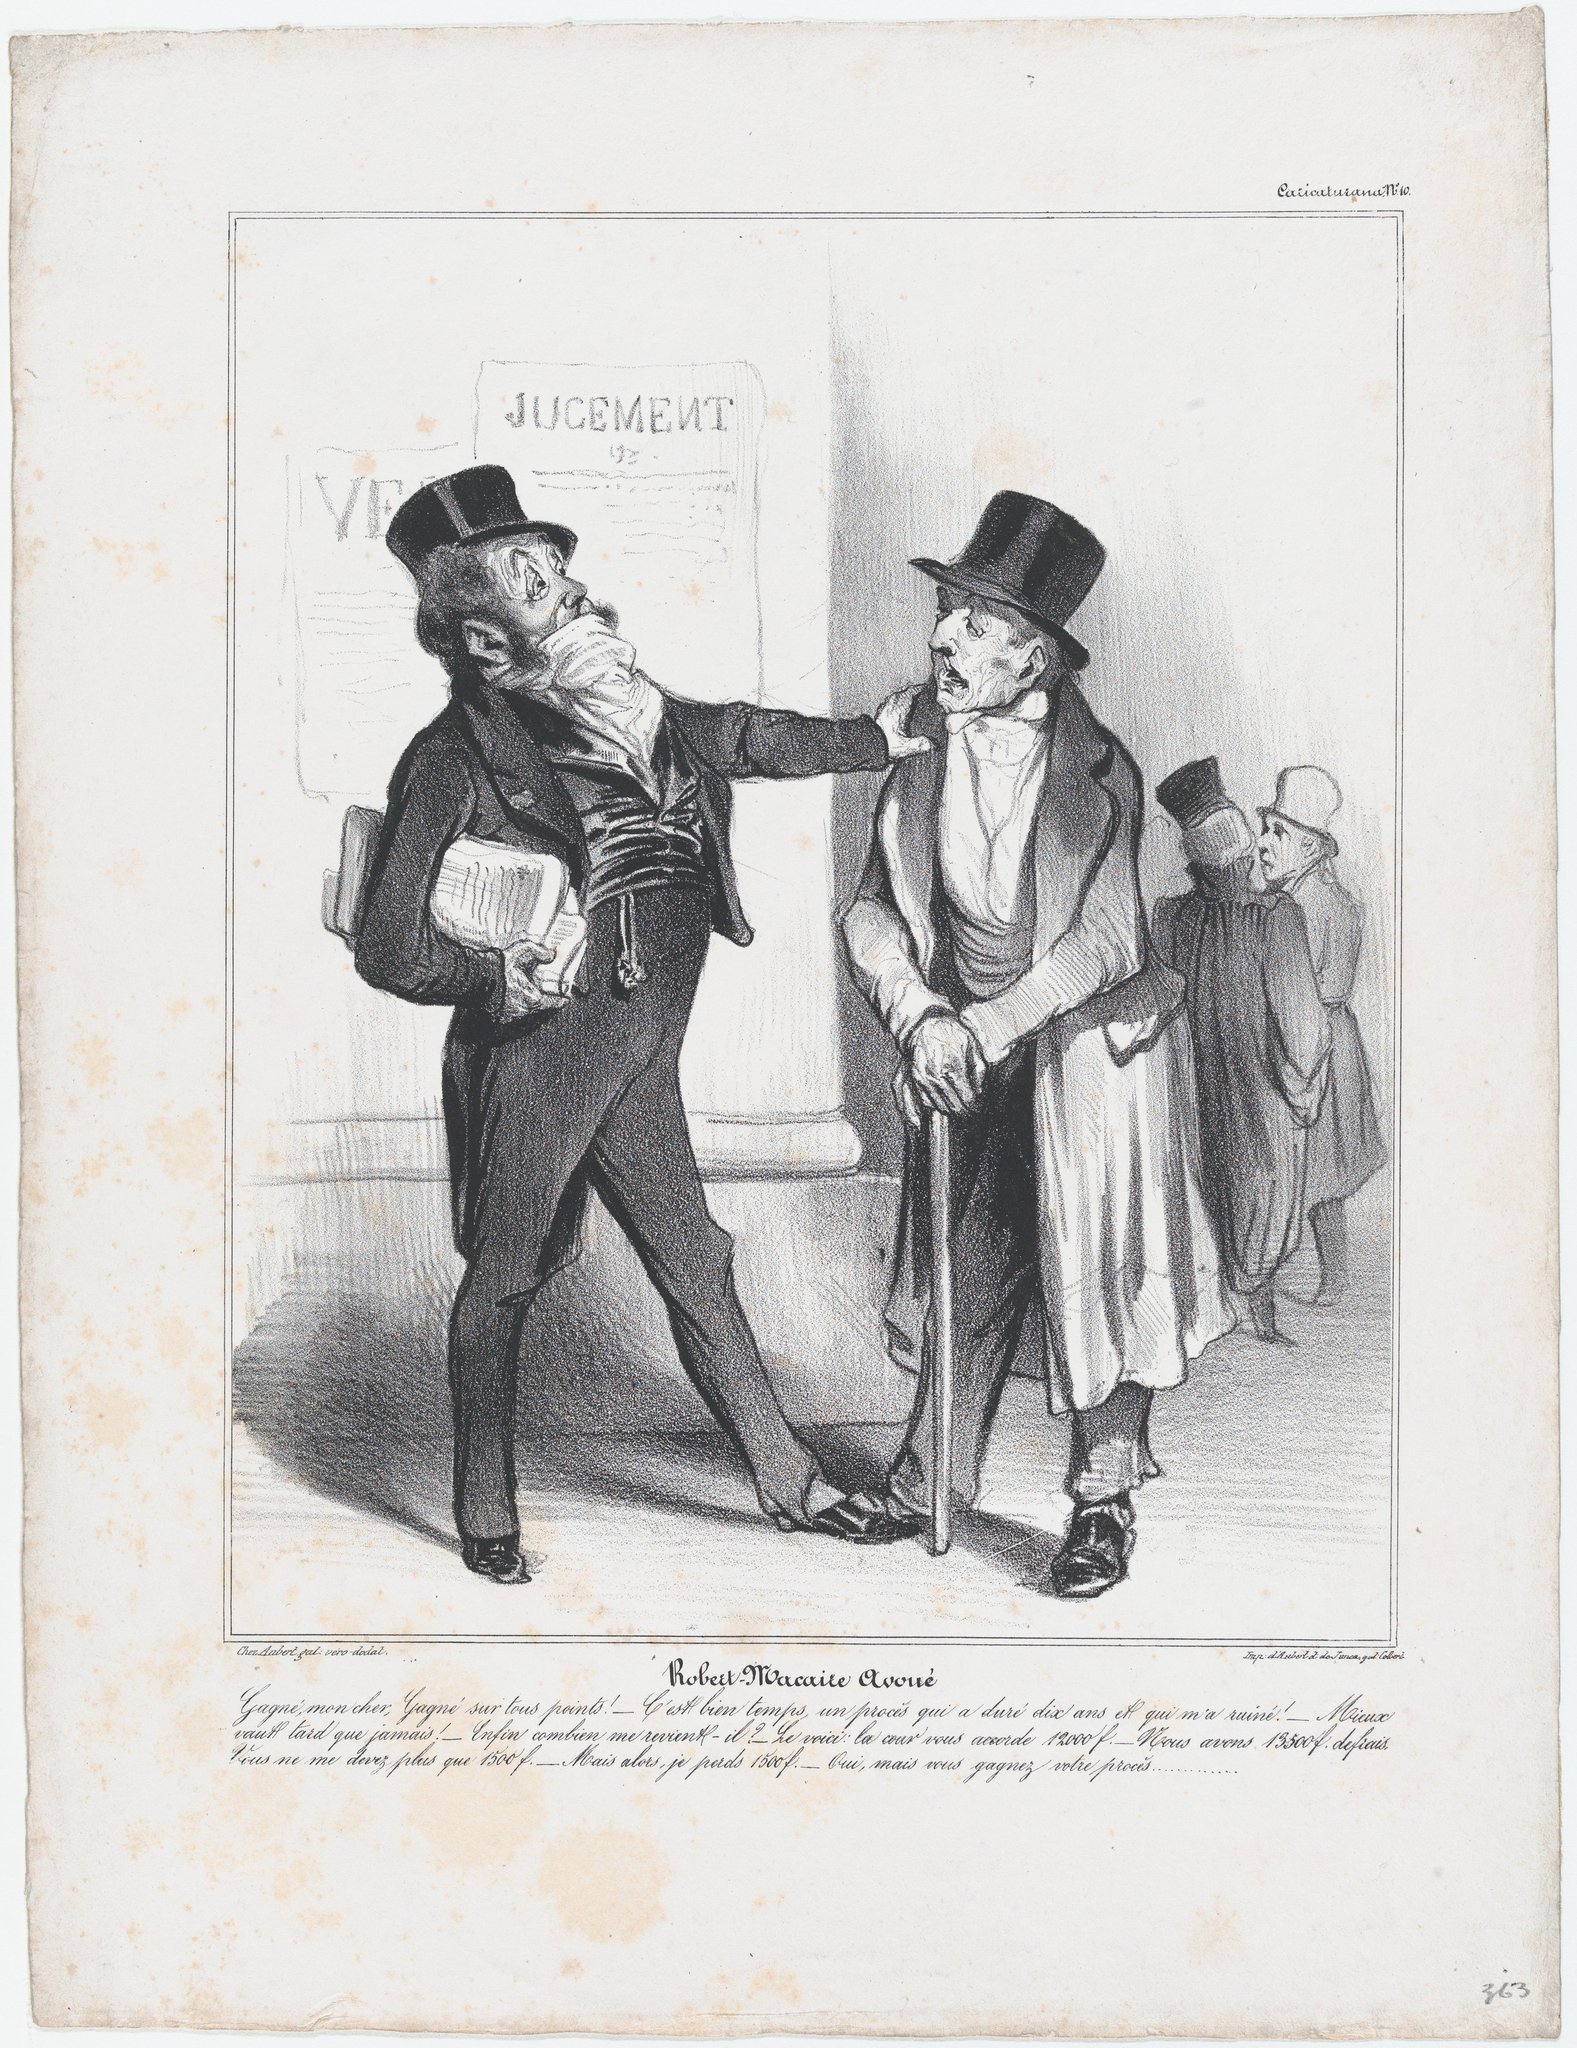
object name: print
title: Plate 10: Robert Macaire, solicitor, from 'Caricaturana,' published in Les Robert Macaires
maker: honoré daumier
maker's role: artist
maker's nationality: french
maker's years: 1808-1879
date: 1838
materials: paper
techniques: lithograph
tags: men